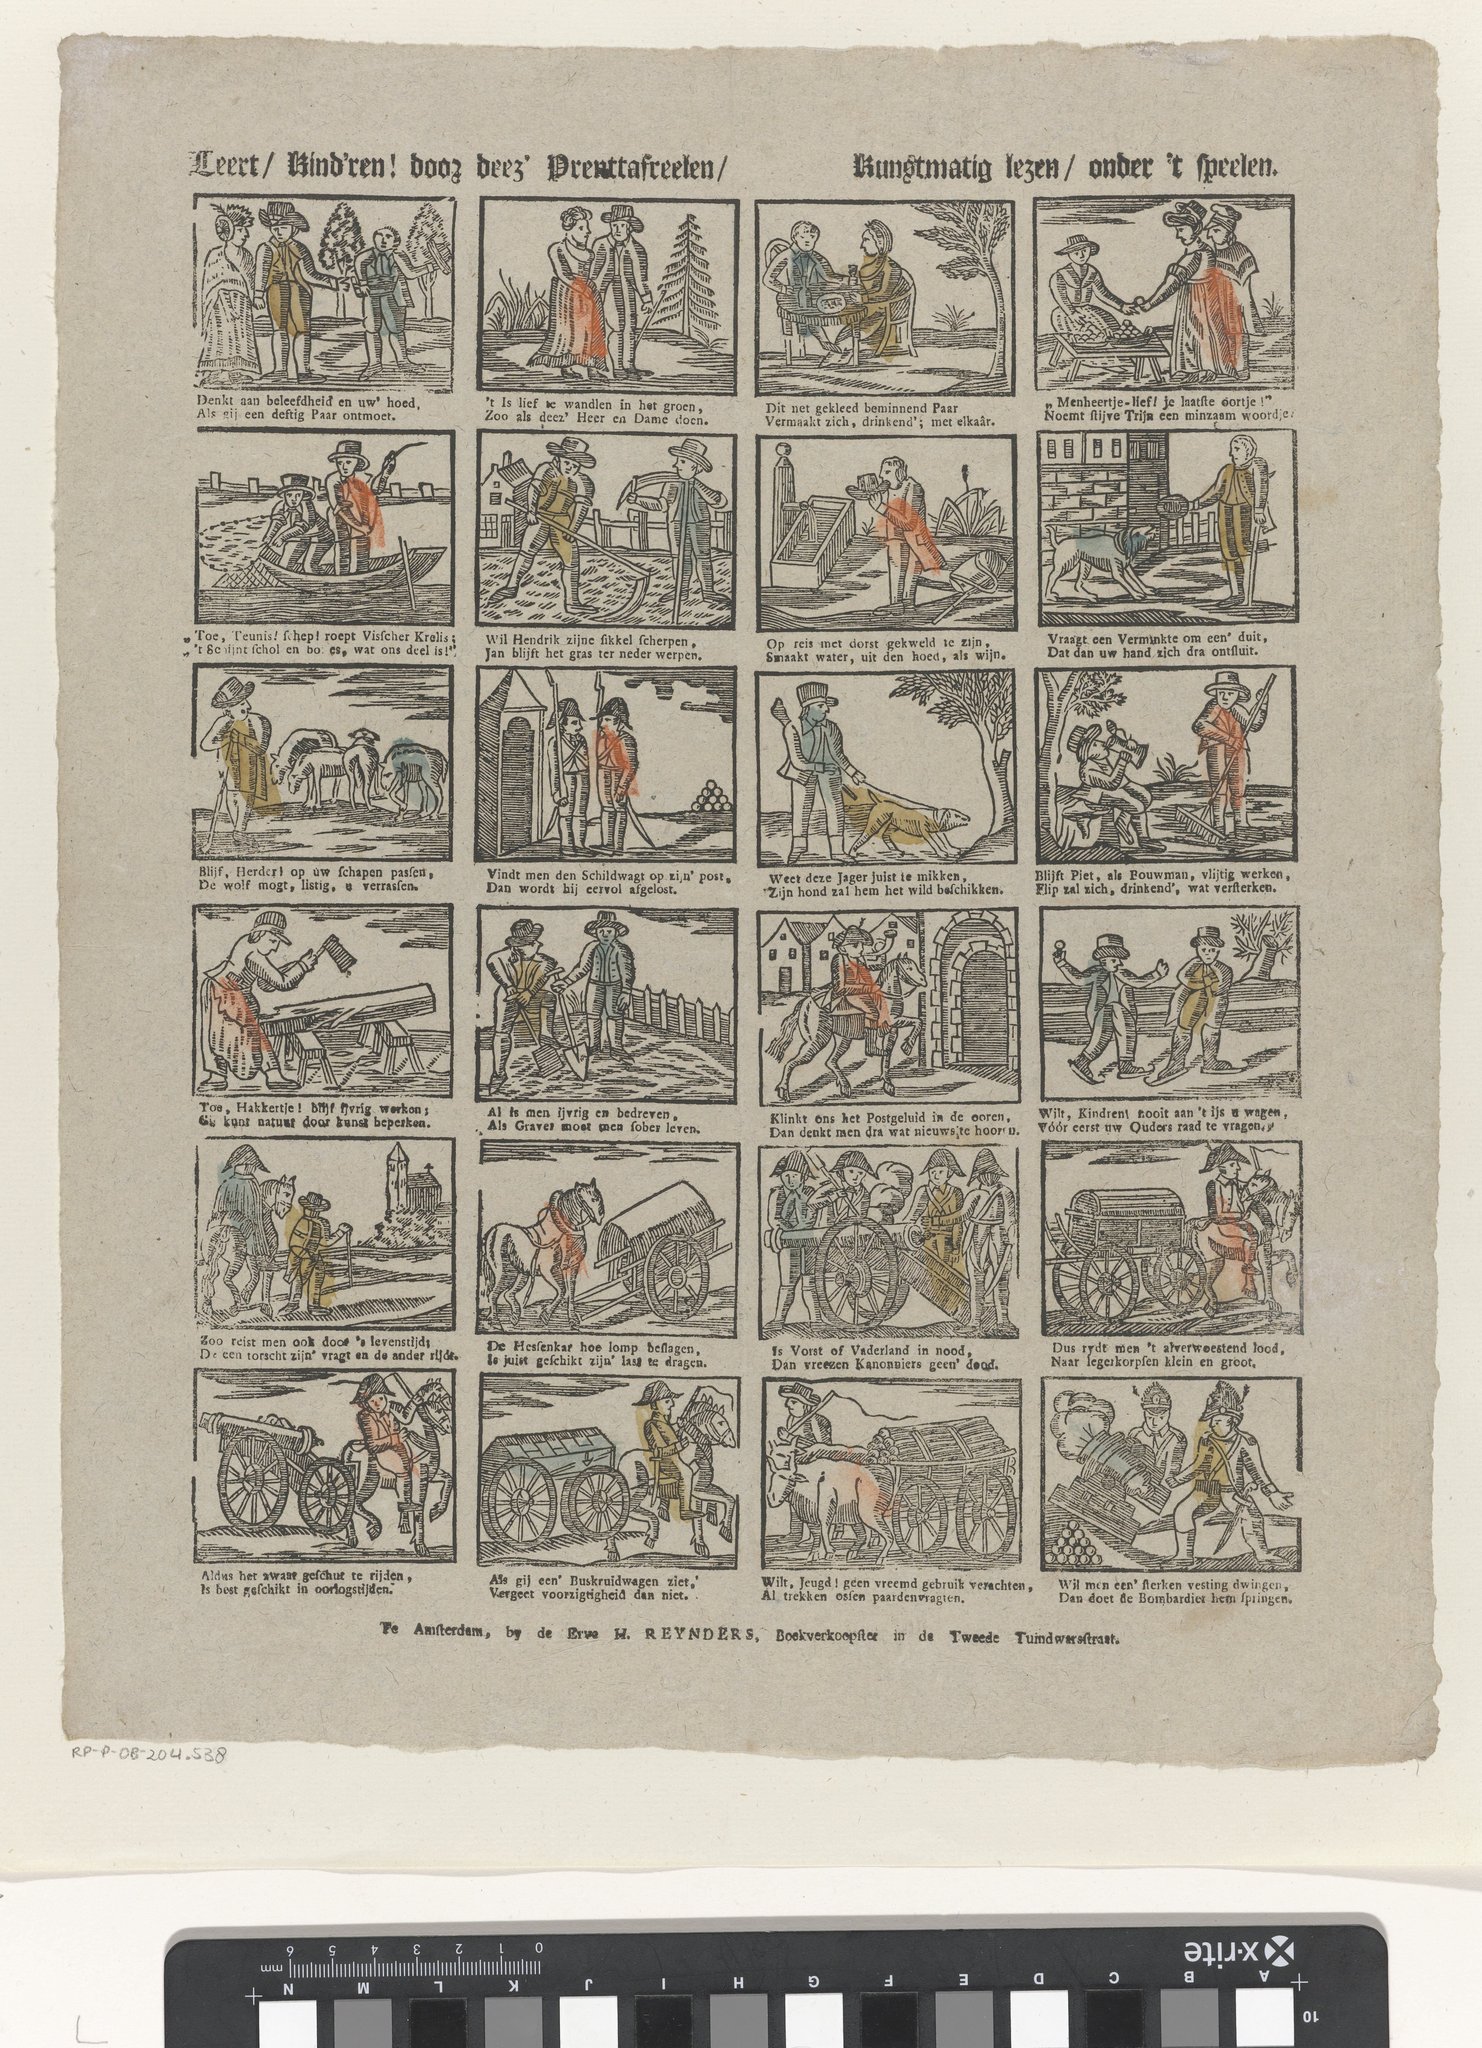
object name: print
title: Leert / kind'ren! door deez' prenttafreelen / Kunstmatig lezen / onder 't speelen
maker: Anonymous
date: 1831-1854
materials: paper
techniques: colour, letterpress printing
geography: amsterdam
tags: human types, farmers, working class, labourers, street-trader, the soldier; the soldier's life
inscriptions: collector's mark: Lugt 2760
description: Blad met 24 voorstellingen van figuren, bezigheden, beroepen en soldaten. Onder elke voorstelling een tweeregelig vers.